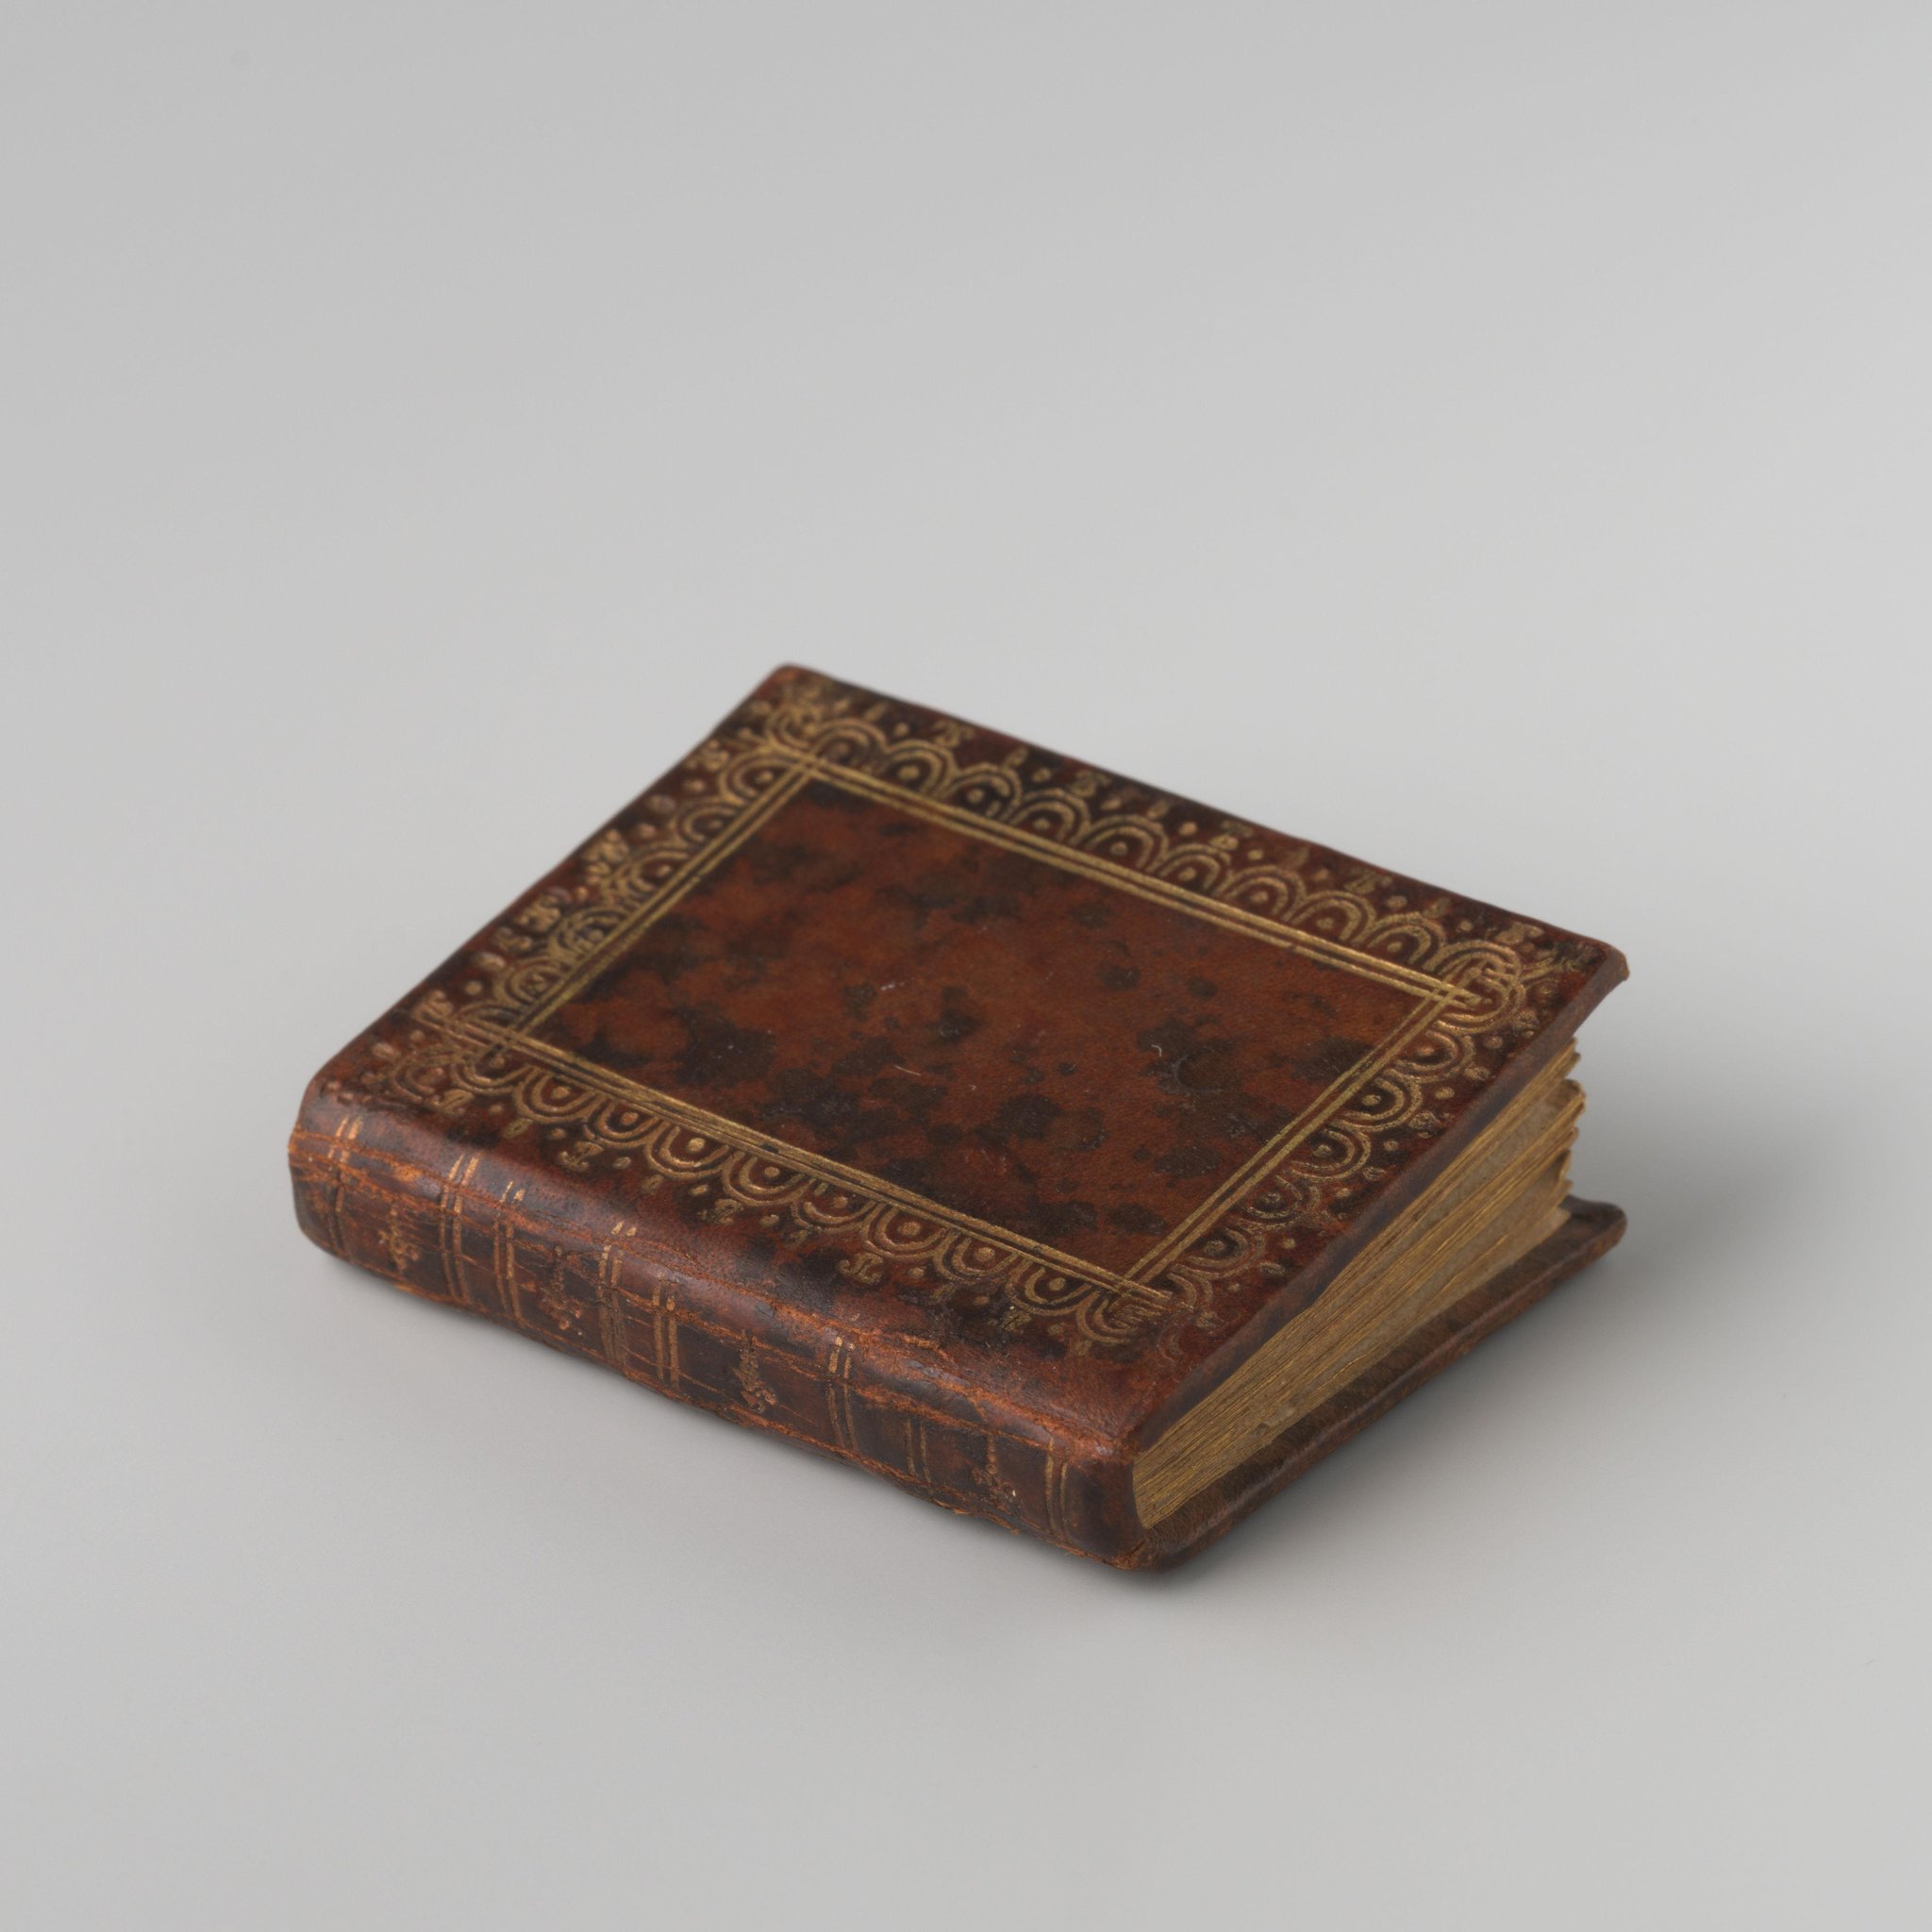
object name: book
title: Boek met figuren en stadsarchitectuur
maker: Anonymous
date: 1690-1710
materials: gold, leather, paper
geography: amsterdam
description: Boek met figuren en stadsarchitectuur. Ingebonden in leer met goudopdruk.